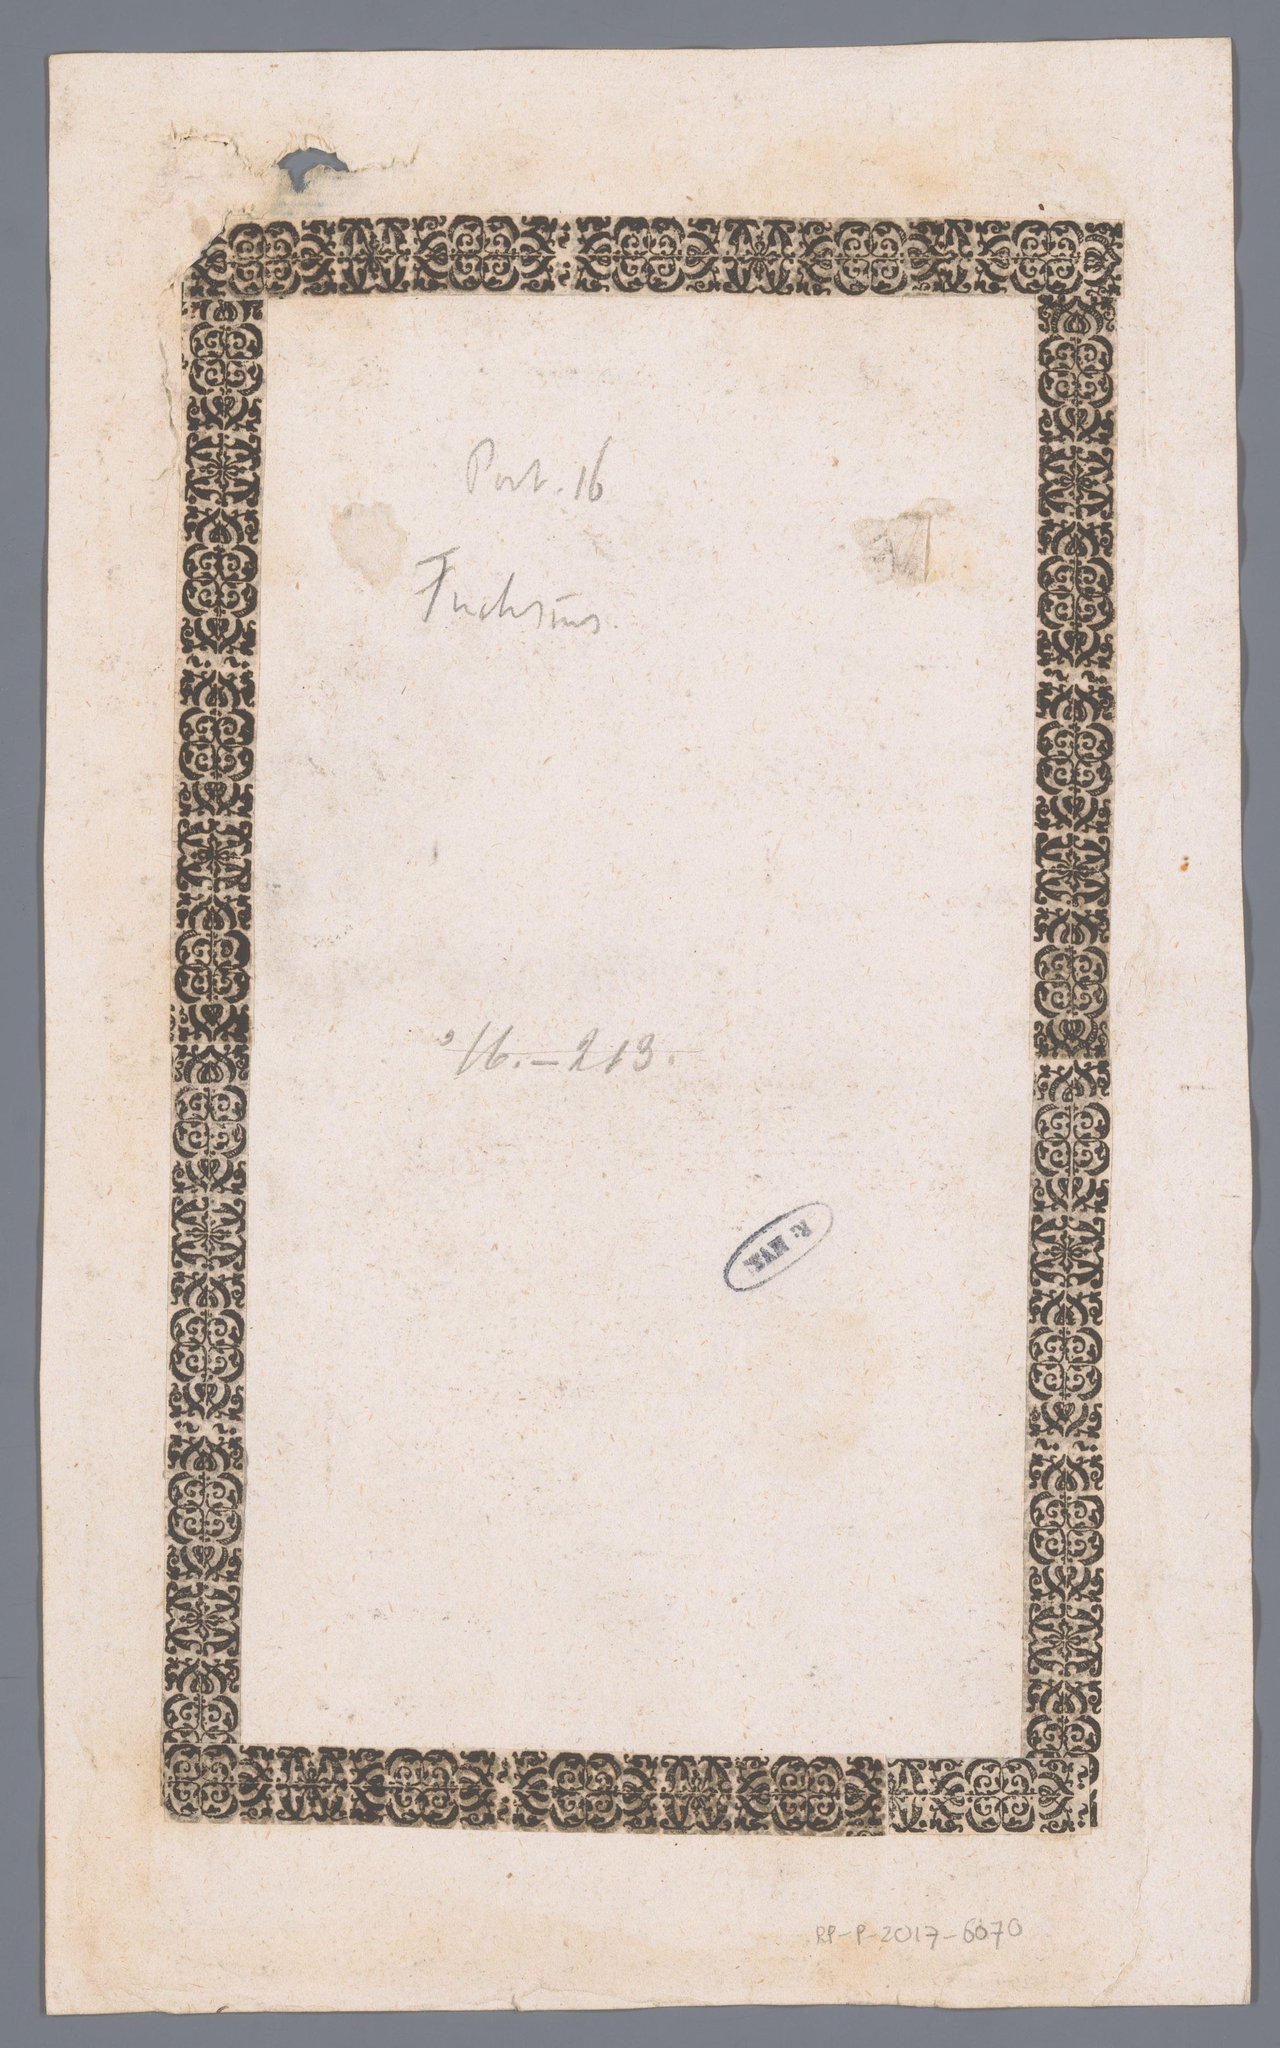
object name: print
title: Ornamentrand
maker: Anonymous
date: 1500-1599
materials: paper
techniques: woodcut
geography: germany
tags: ornaments ~ art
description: Acht stroken gemonteerd als één ornamentrand.